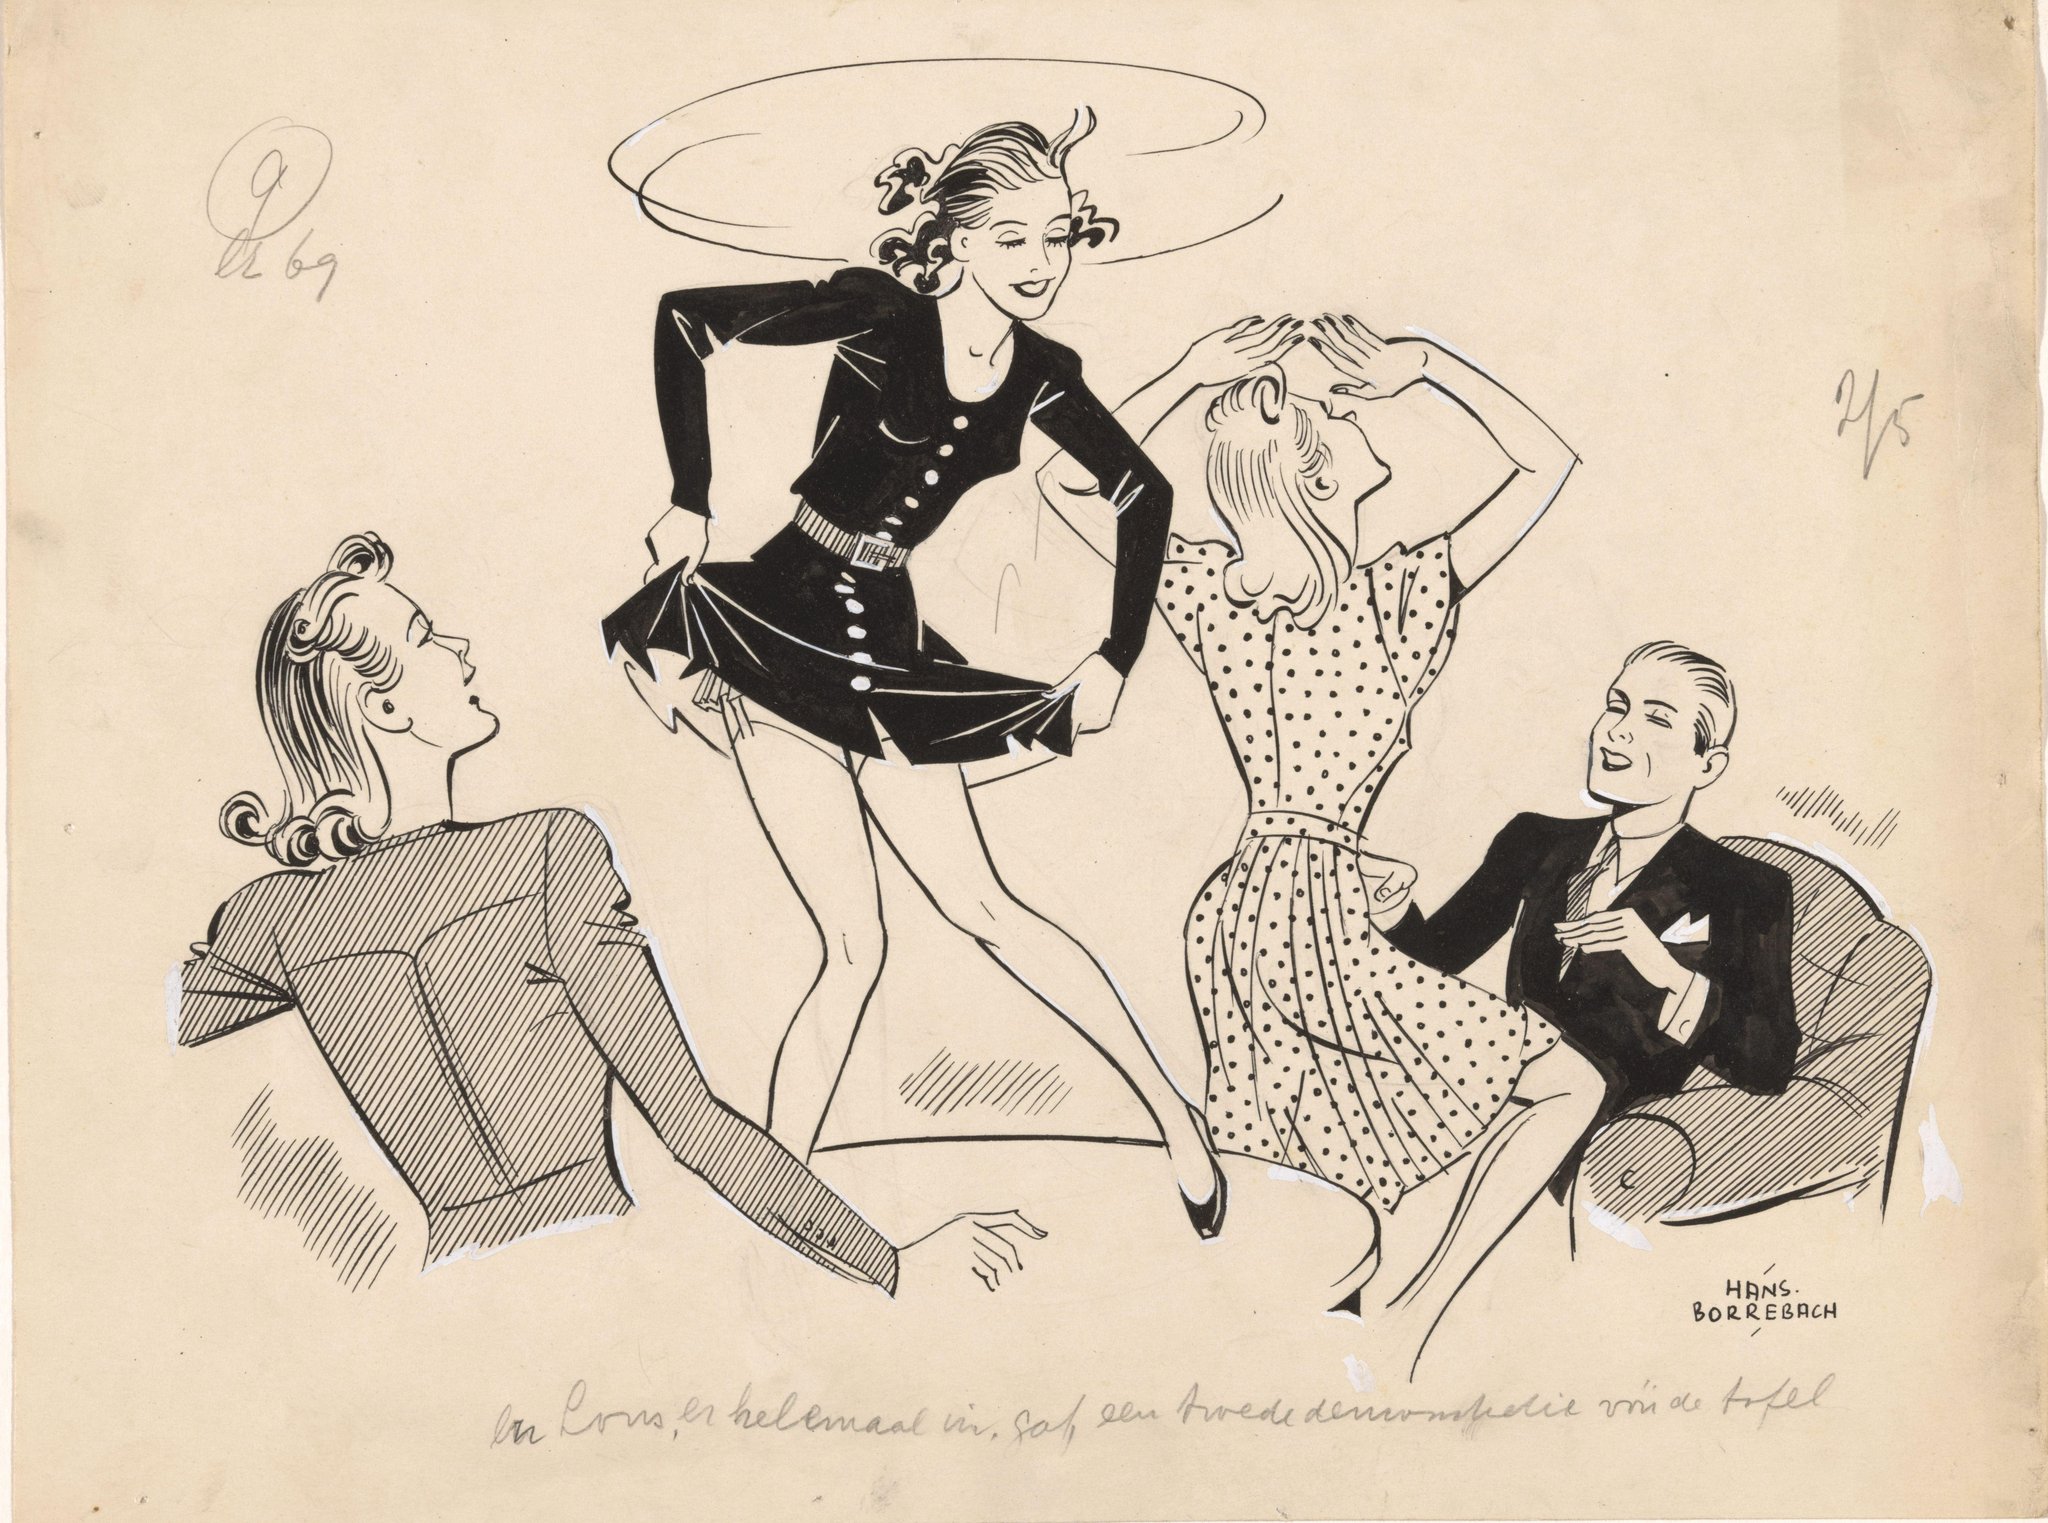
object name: drawing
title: Pepita danst op een tafel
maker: hans borrebach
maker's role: draughtsman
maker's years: 1903-1991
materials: paint, ink, paper, pencil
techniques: brush, pen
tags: armchair, seat, dancing, table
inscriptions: :, collector's mark: Lugt 2228a, signature: ‘HANS./ BORREBACH’, annotation: ‘9/ bz 69/ en Lous, er helemaal in, gaf een tweede demonstratie vóór de tafel’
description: Pepita danst op een tafel en tilt haar rok iets omhoog. Naast de tafel dansen twee jongen vrouwen en kijkt een jonge man in een leunstoel toe.